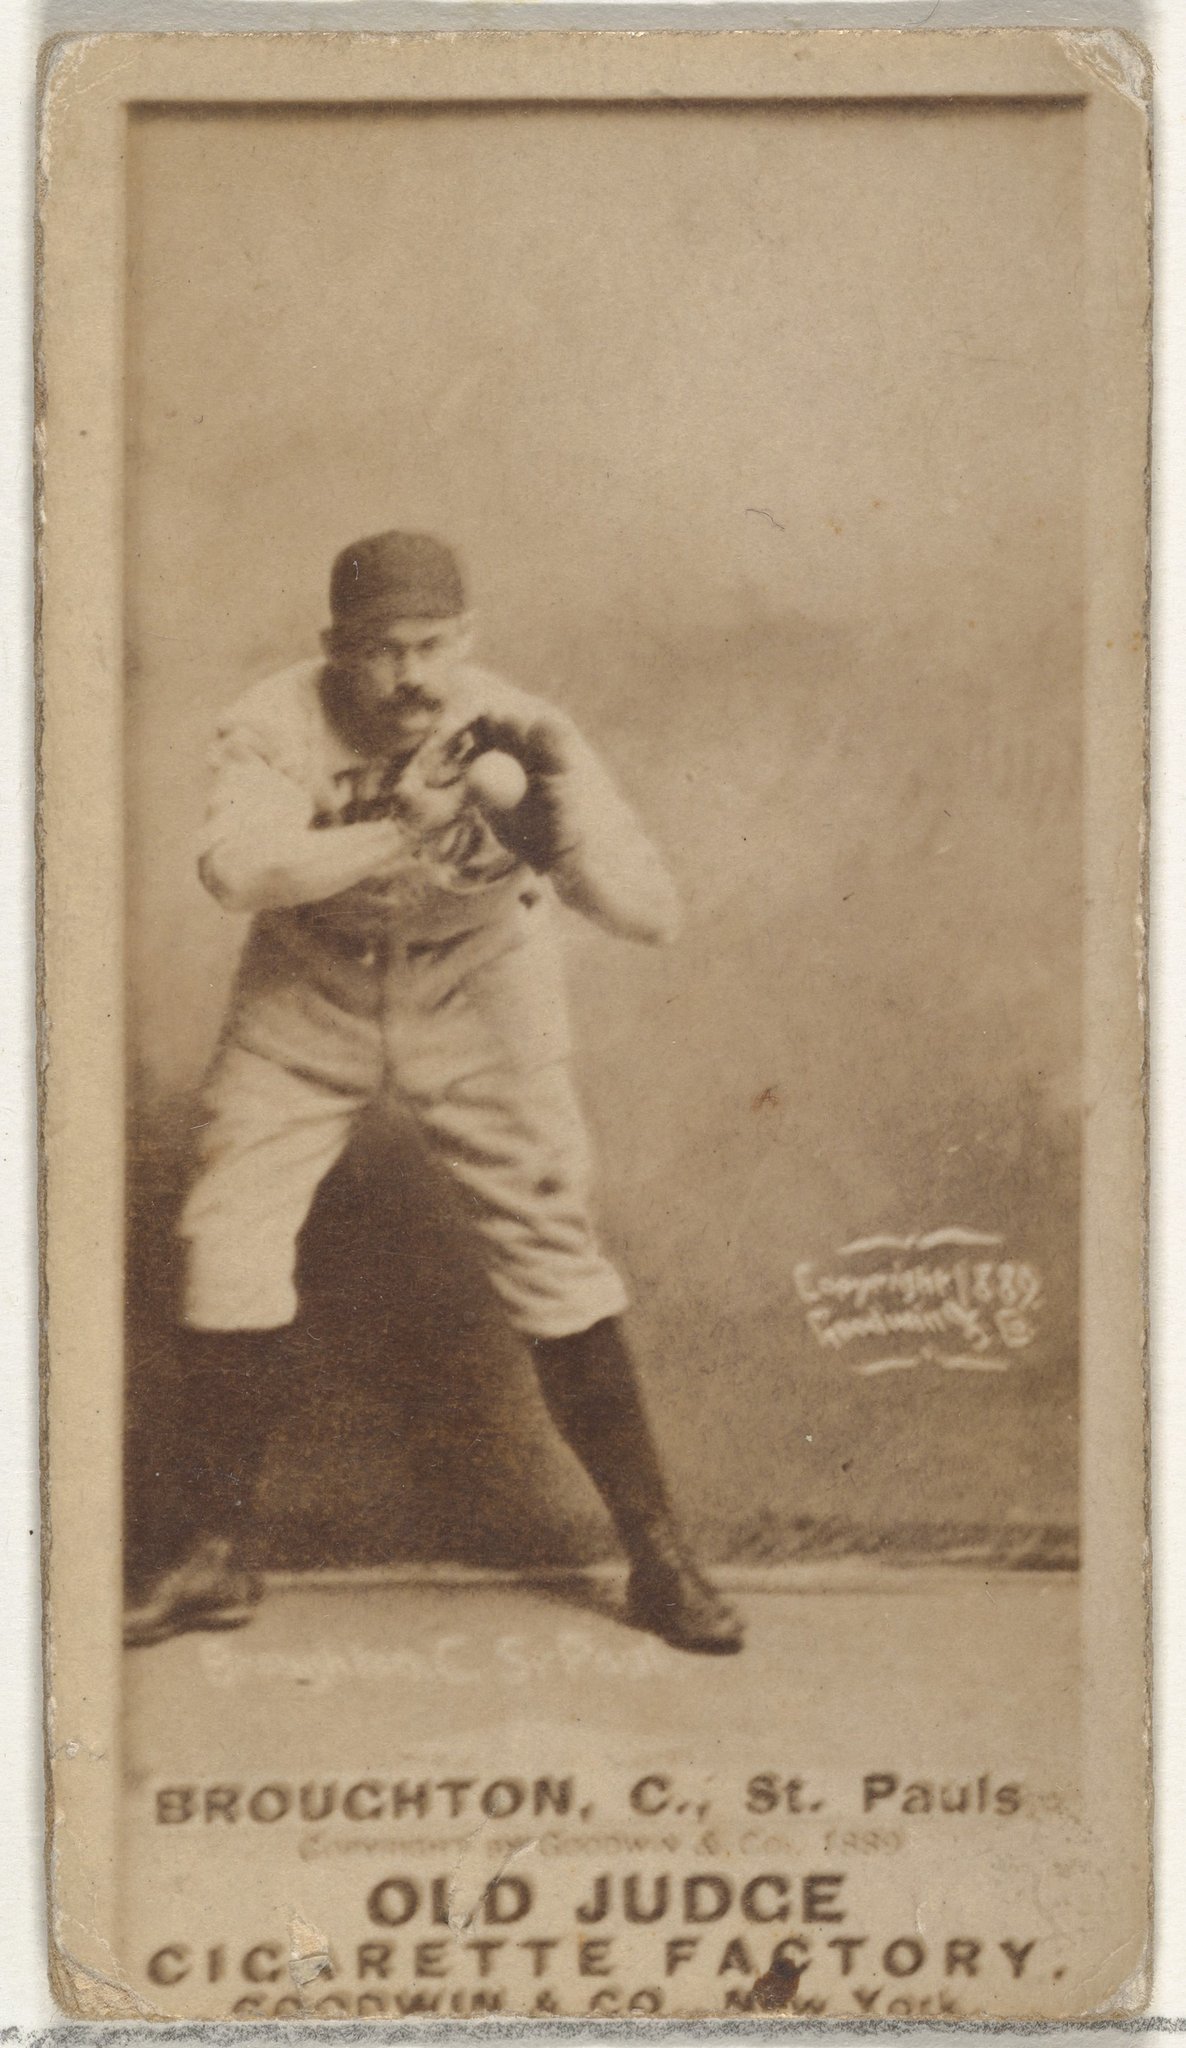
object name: baseball card, photograph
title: Cecil Calvert "Cal" Broughton, Catcher, St. Paul Apostles, from the Old Judge series (N172) for Old Judge Cigarettes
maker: goodwin & company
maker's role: publisher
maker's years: 1850-1950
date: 1889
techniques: albumen silver print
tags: men,portraits,baseball,athletes